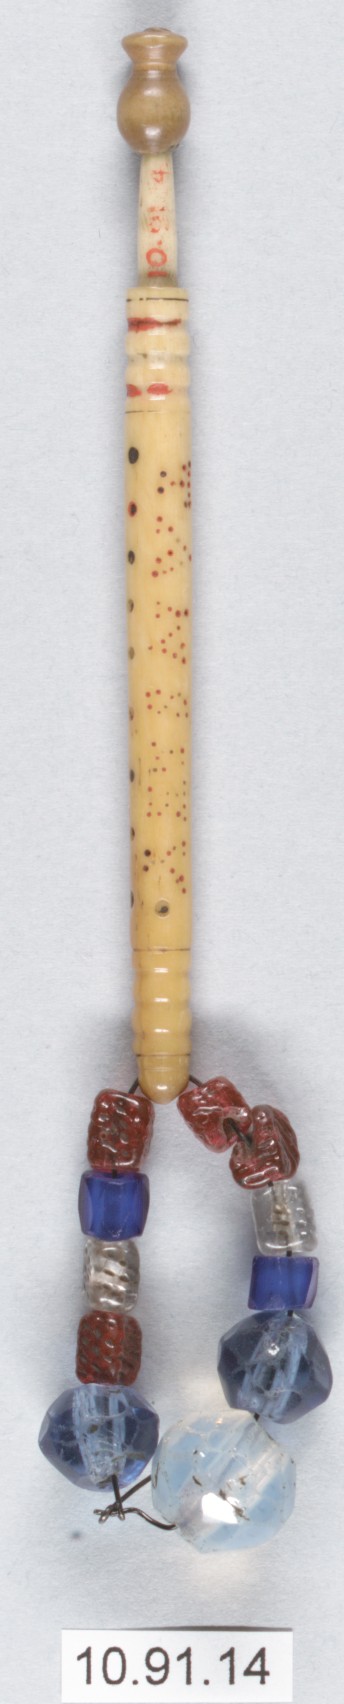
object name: bobbin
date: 1801-1900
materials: bone